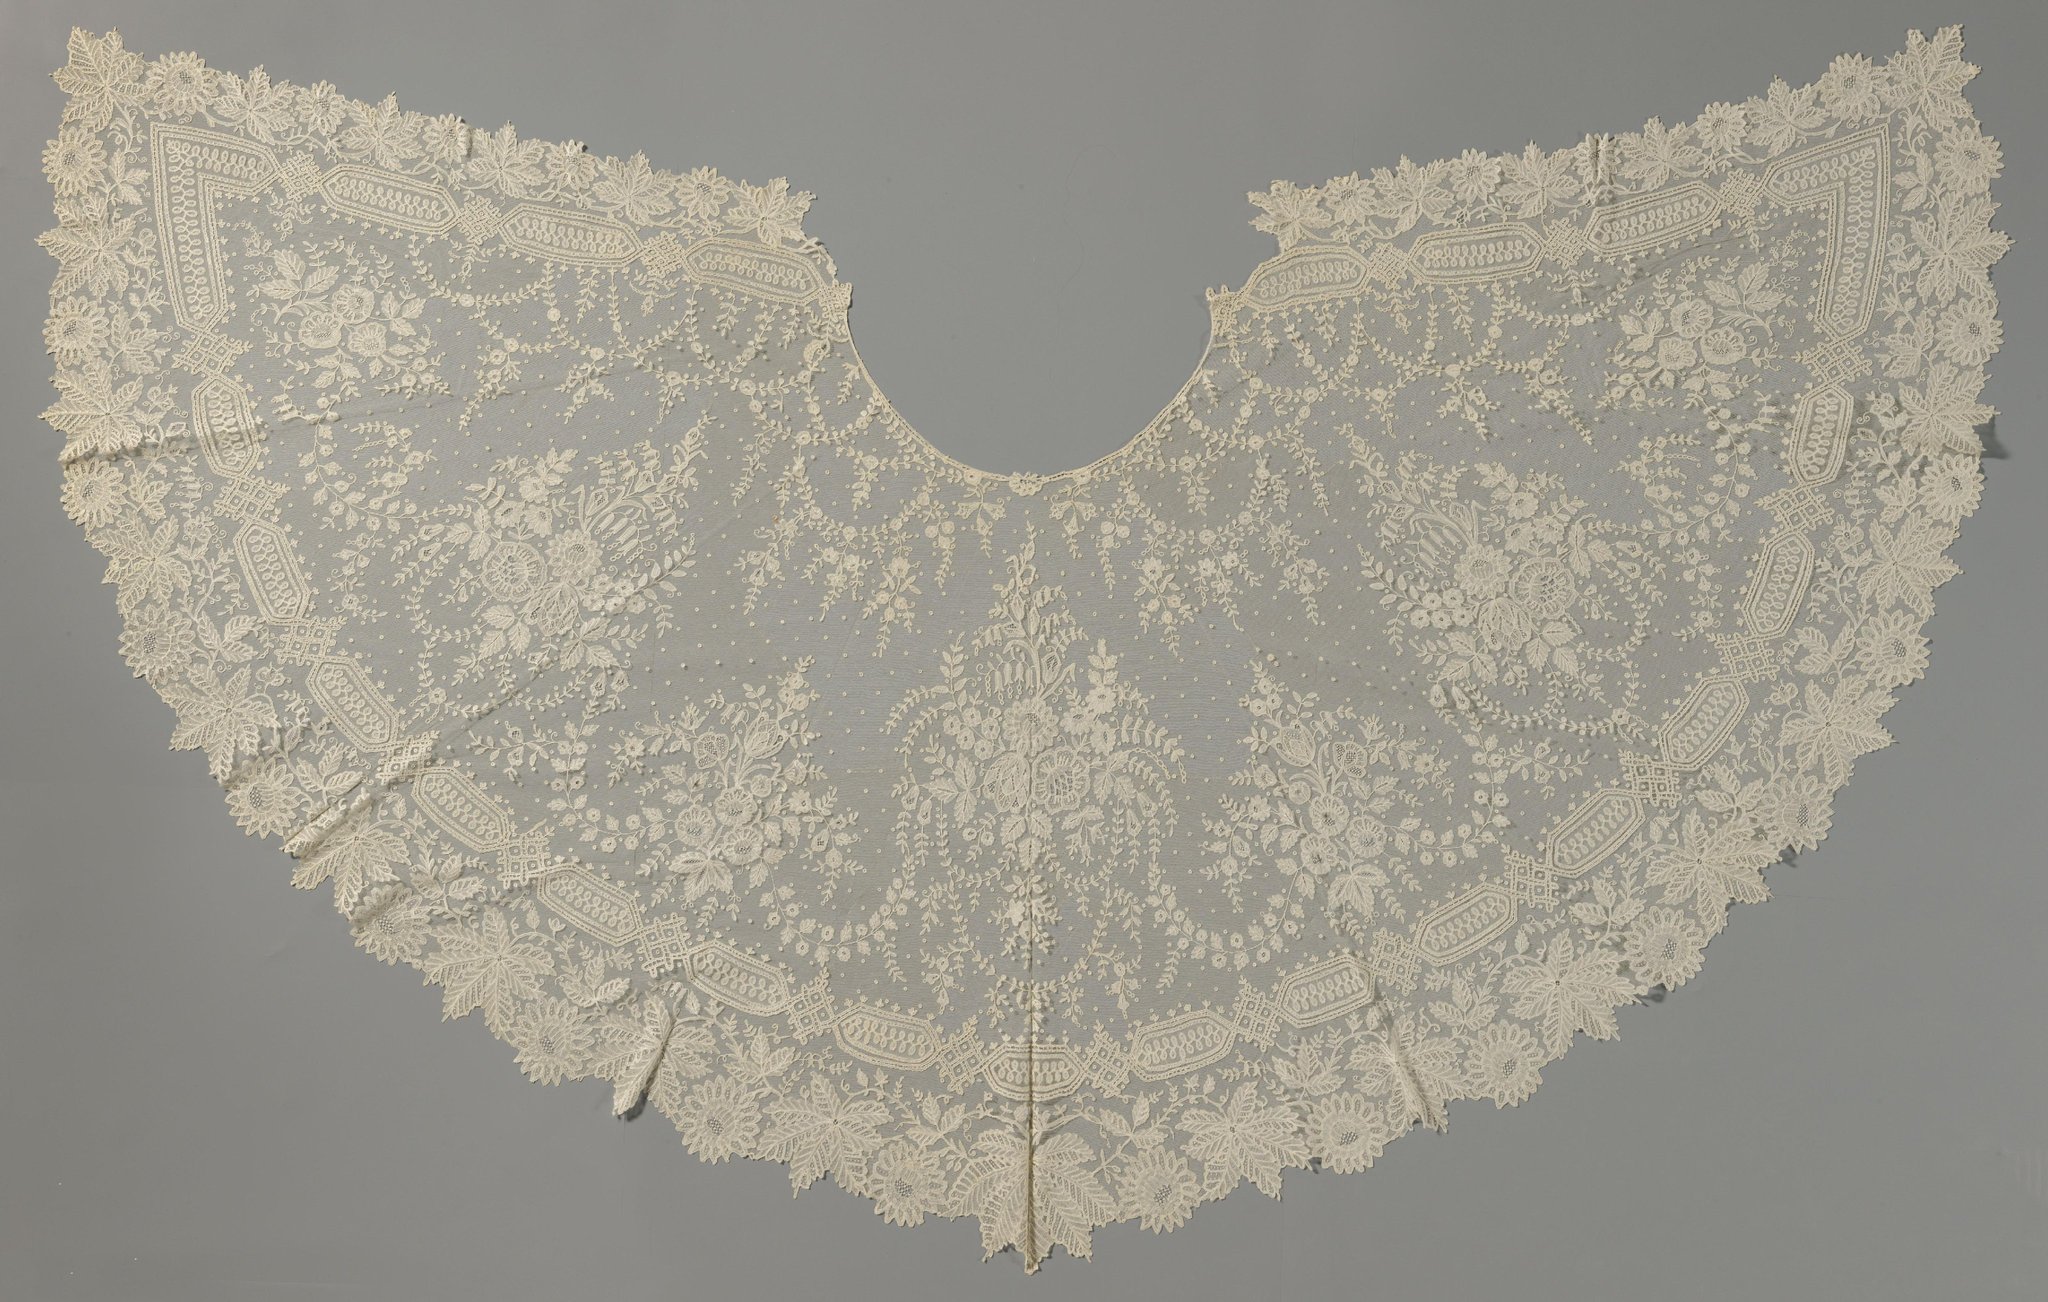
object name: cloak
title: Cape van applicatiekant met schakelband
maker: Anonymous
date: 1860-1870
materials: linen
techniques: lace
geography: sluis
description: Cape van naturelkleurige applicatiekant, kloskant en enig naaldkant geappliceerd op machinale tule. Een cirkelvormig model vertoont een grillig geschulpte omtrek van een groot kastanjeblad, afgewisseled met een dahlia. Binnen deze rand loopt een schakelband van gerekte zeszijdige schakels (naaldkant), verbonden door een ruitvorm van vlechtwerk. Het middenveld, dat met grote moesjes in de vorm van pailletten is bezaaid, vertoont drie grote boeketten, onder andere met een tulp waarvan talrijke bladslingers afhangen. Deze slingers vormen de verbindingen met vier tussenliggende kleinere boeketten. Vele slingerboogjes kruisen elkaar langs de halslijn en de voorste randen.